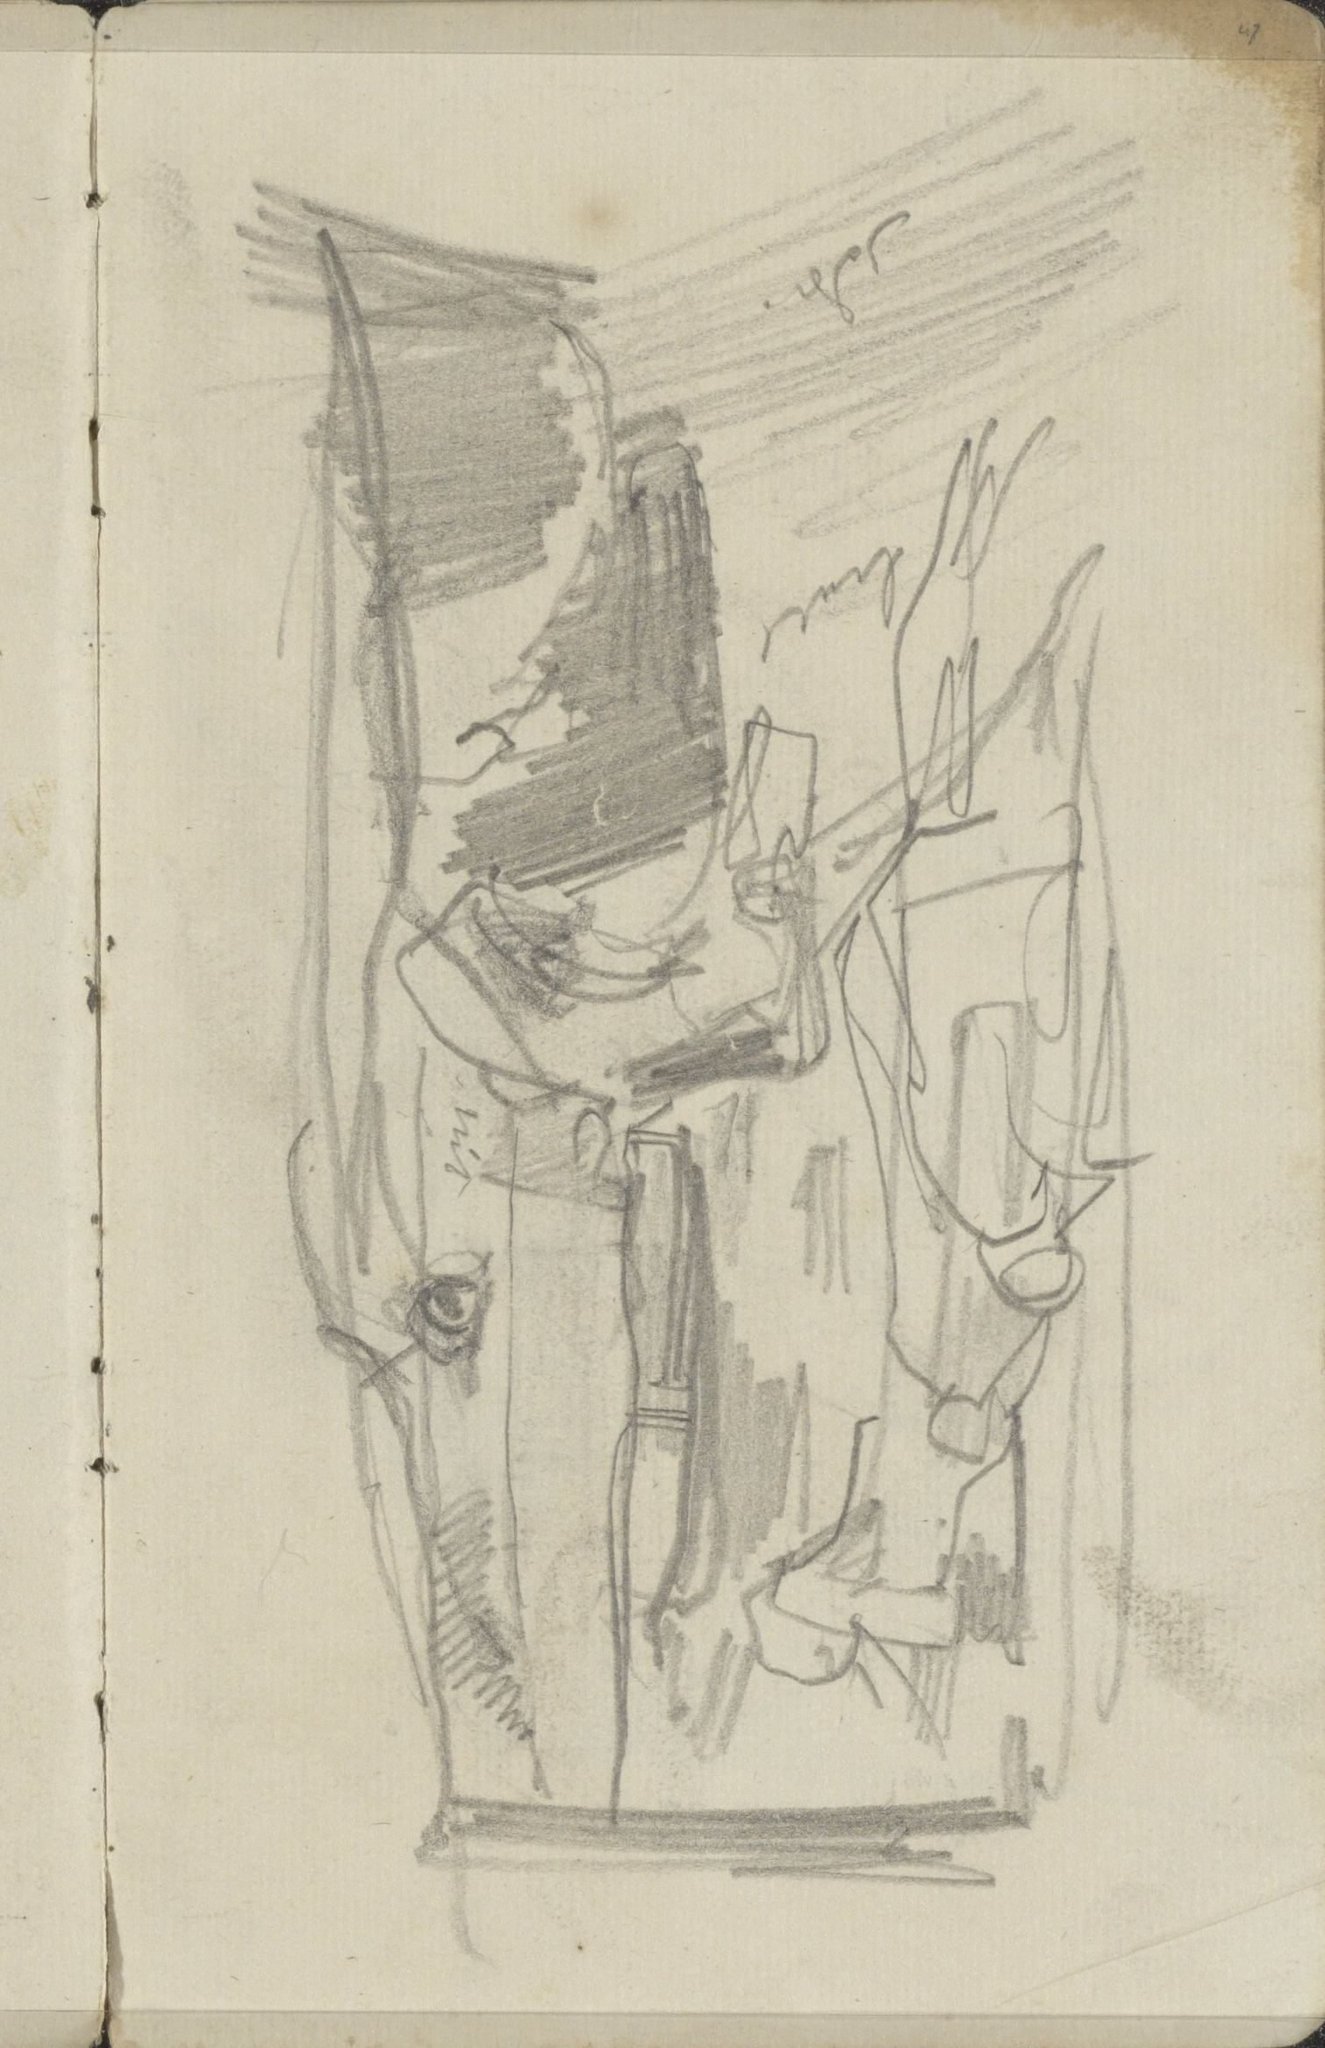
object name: sketchbook leaf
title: Figuren, mogelijk op straat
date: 1881-1883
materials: paper, pencil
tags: mule, street (+ city(-scape) with figures, staffage)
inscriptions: kleurnotitie, handgeschreven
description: Ook mogelijk een muildier met vracht. Pagina 47 uit een schetsboek met 29 bladen.